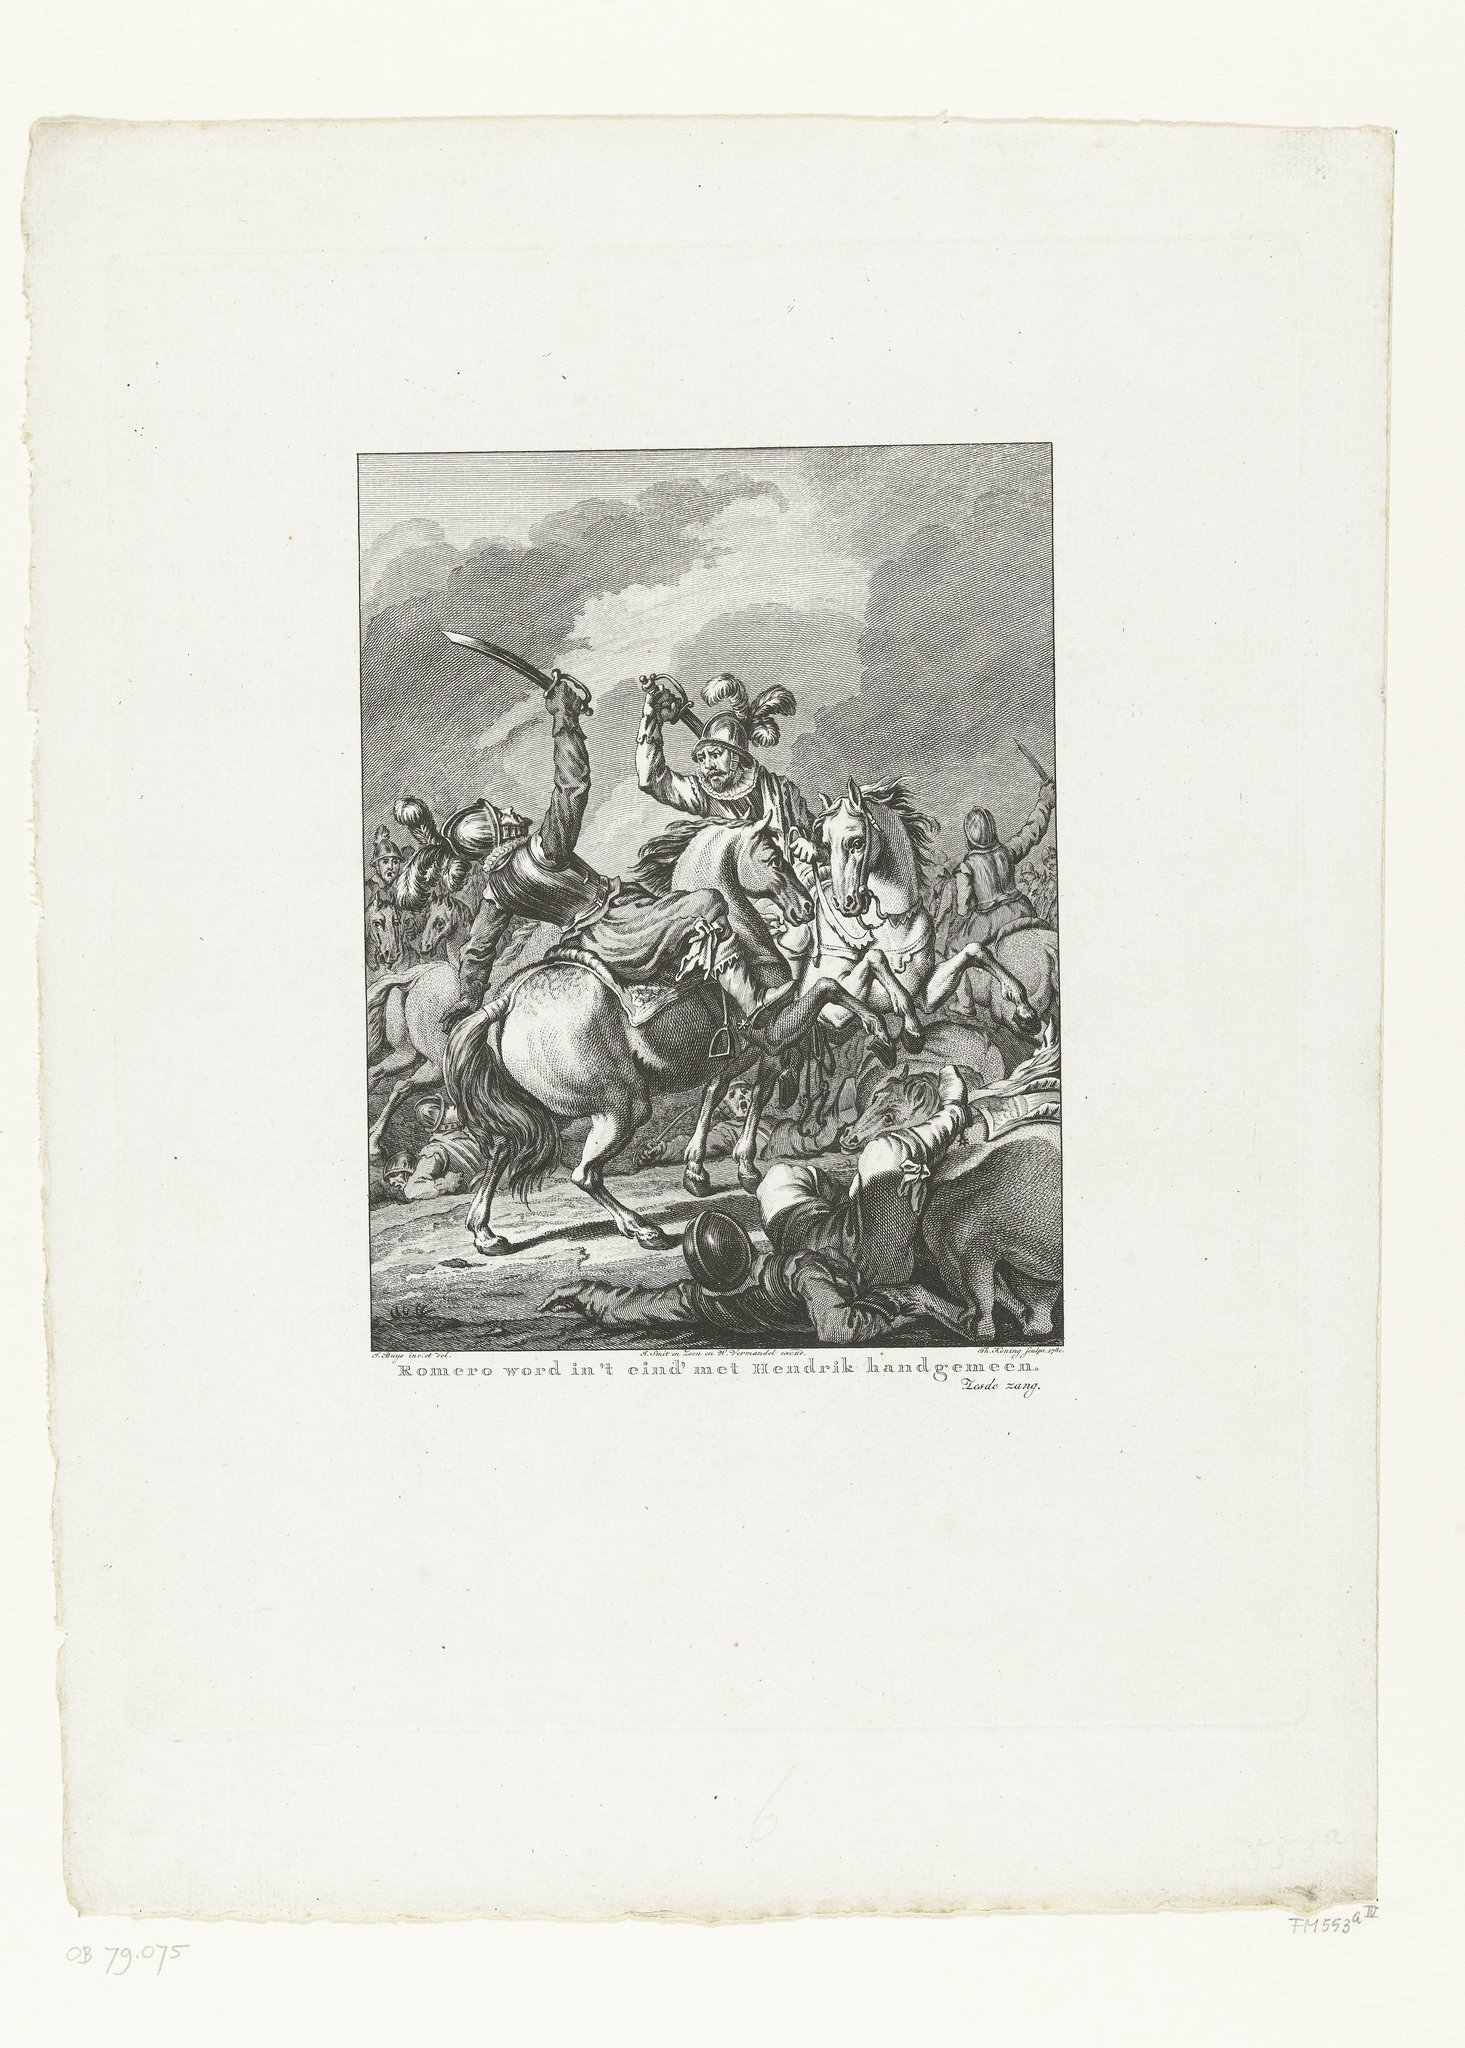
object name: history print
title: Gevecht tussen Romero en Hendrik van Nassau bij Mons, 1572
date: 1780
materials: paper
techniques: etching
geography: amsterdam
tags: battle, fighting in general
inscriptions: date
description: Illustratie voor: J. Nomsz, Willem de eerste, of de grondlegging der Nederlandsche vryheid. : In vier en twintig zangen, Erven van David Klippink, Amsterdam 1779. Staat met de letter.